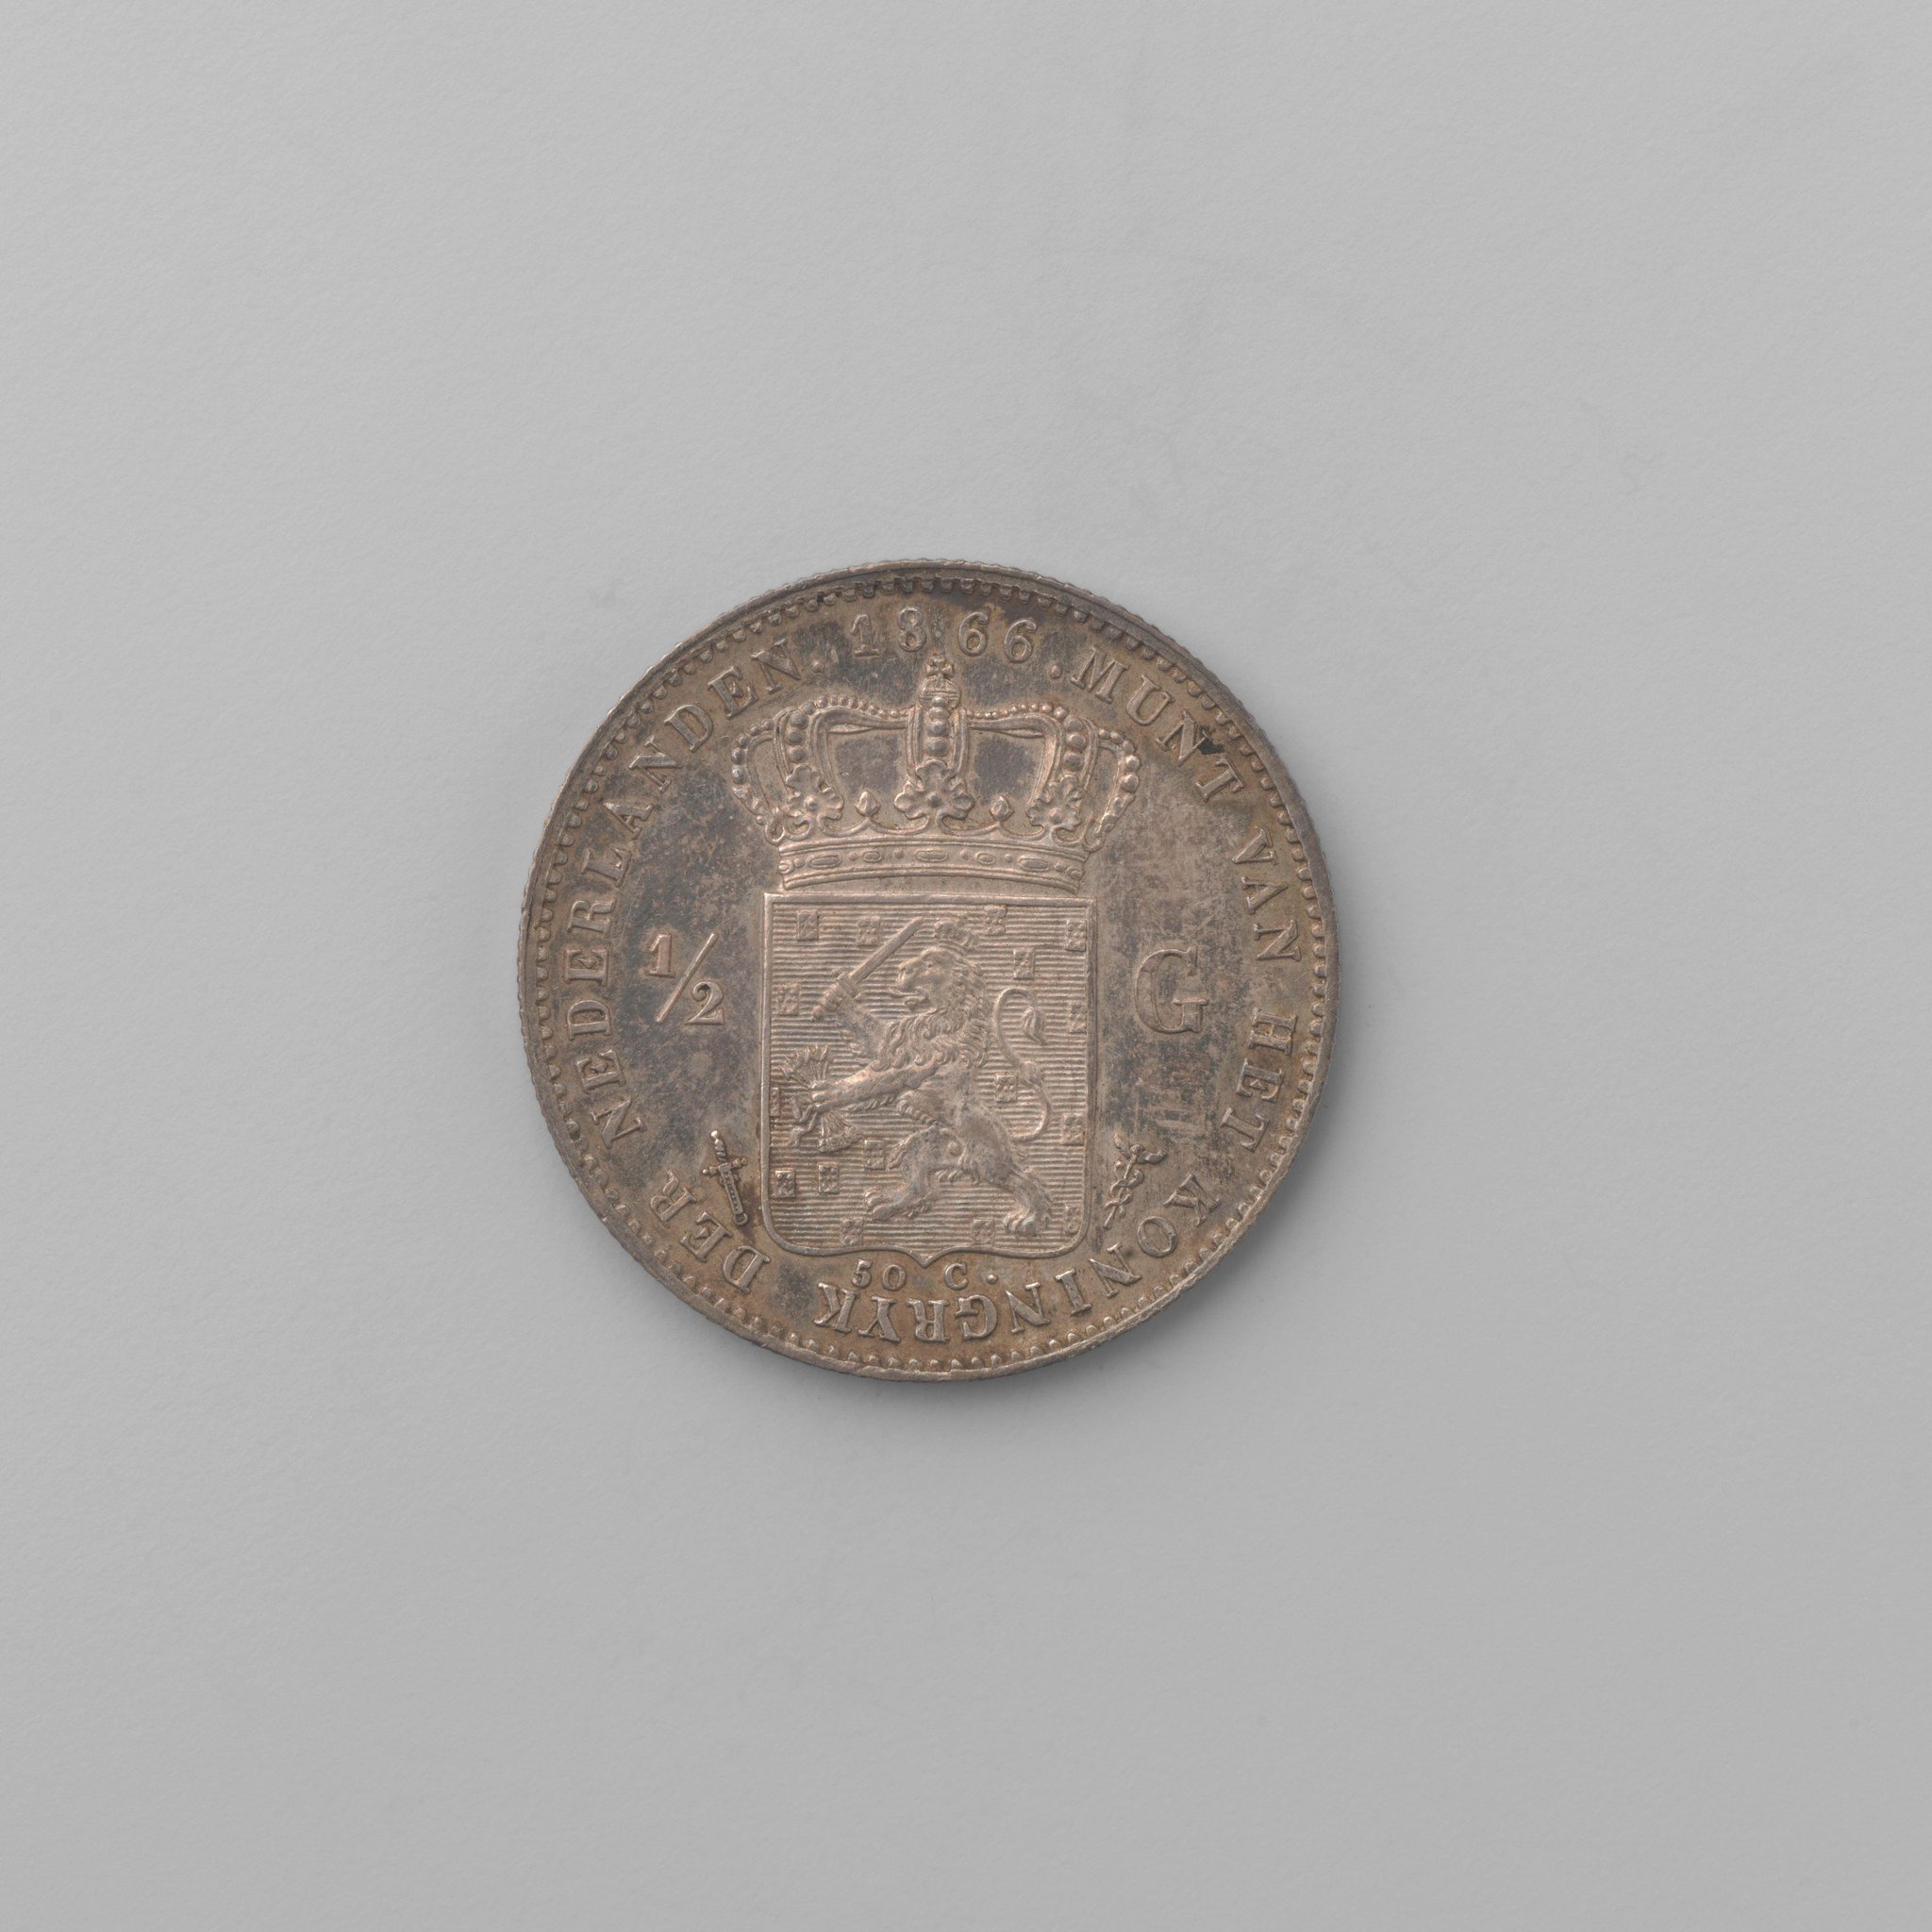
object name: coin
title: Nederlandse ½ gulden, 1866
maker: willem iii (koning der nederlanden)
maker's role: koning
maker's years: 1817-1890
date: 1866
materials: silver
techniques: striking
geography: utrecht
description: Zilveren munt. Voorzijde: borstbeeld naar rechts. Keerzijde: tussen waarde-aanduiding ½ G gekroond rijkswapenschild. Jaartal boven kroon. Kartelrand.